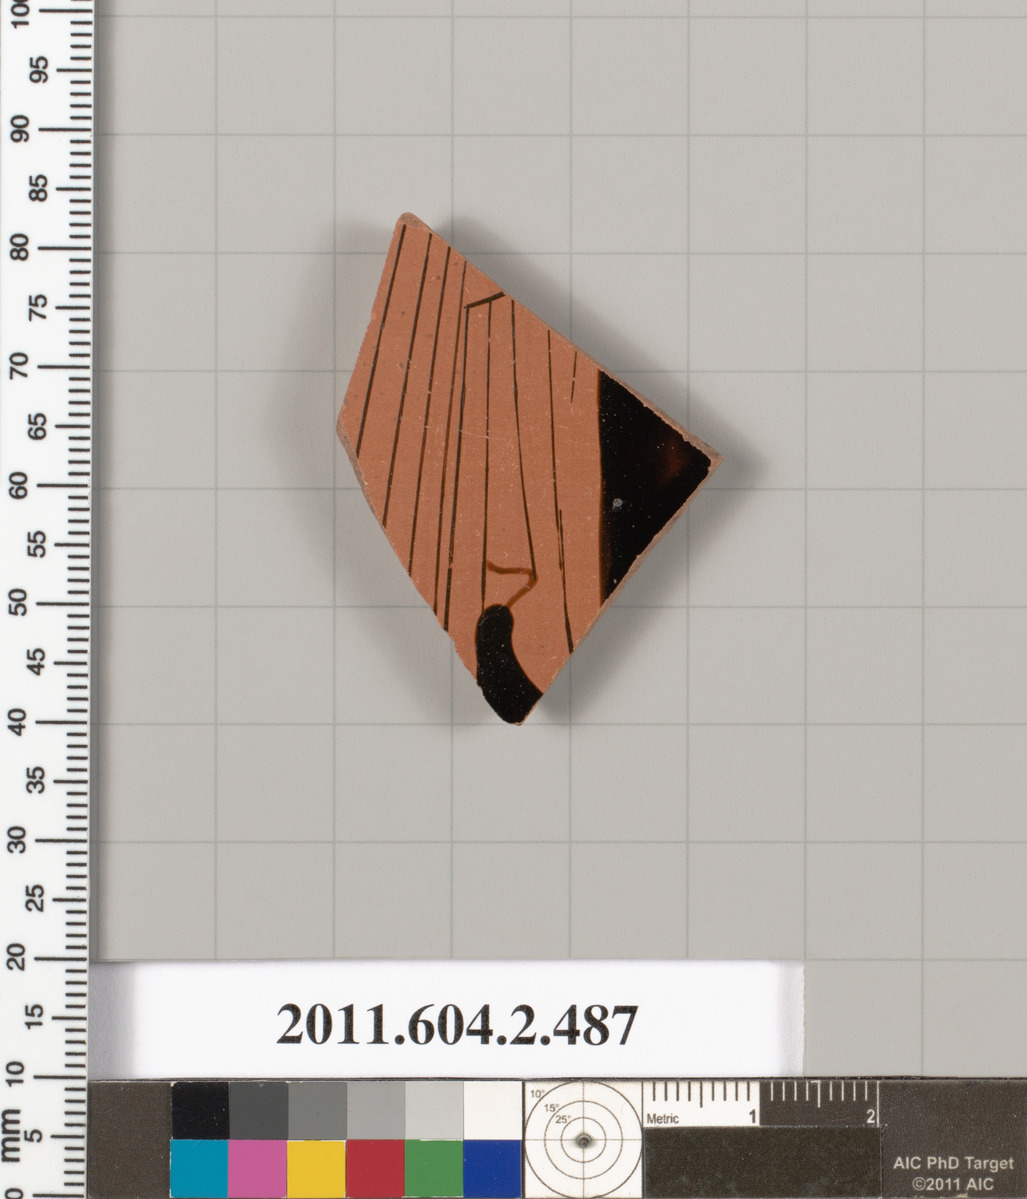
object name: column krater fragment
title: Terracotta fragment of a column-krater (bowl for mixing wine and water)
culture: greek, attic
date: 460-440 BCE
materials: terracotta